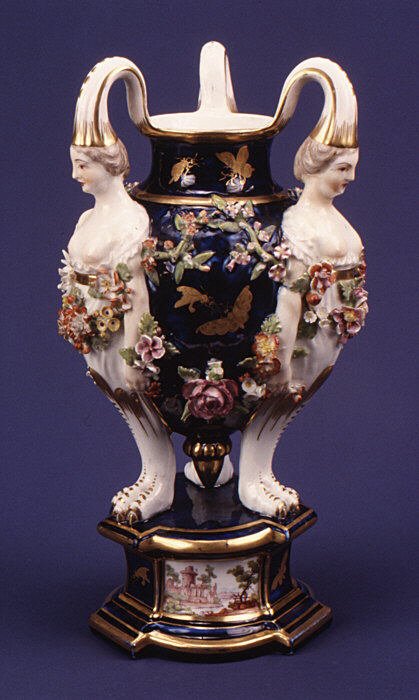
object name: incense burner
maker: chelsea porcelain manufactory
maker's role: factory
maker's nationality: british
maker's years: 1744-1784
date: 1770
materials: soft paste porcelain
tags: caryatids